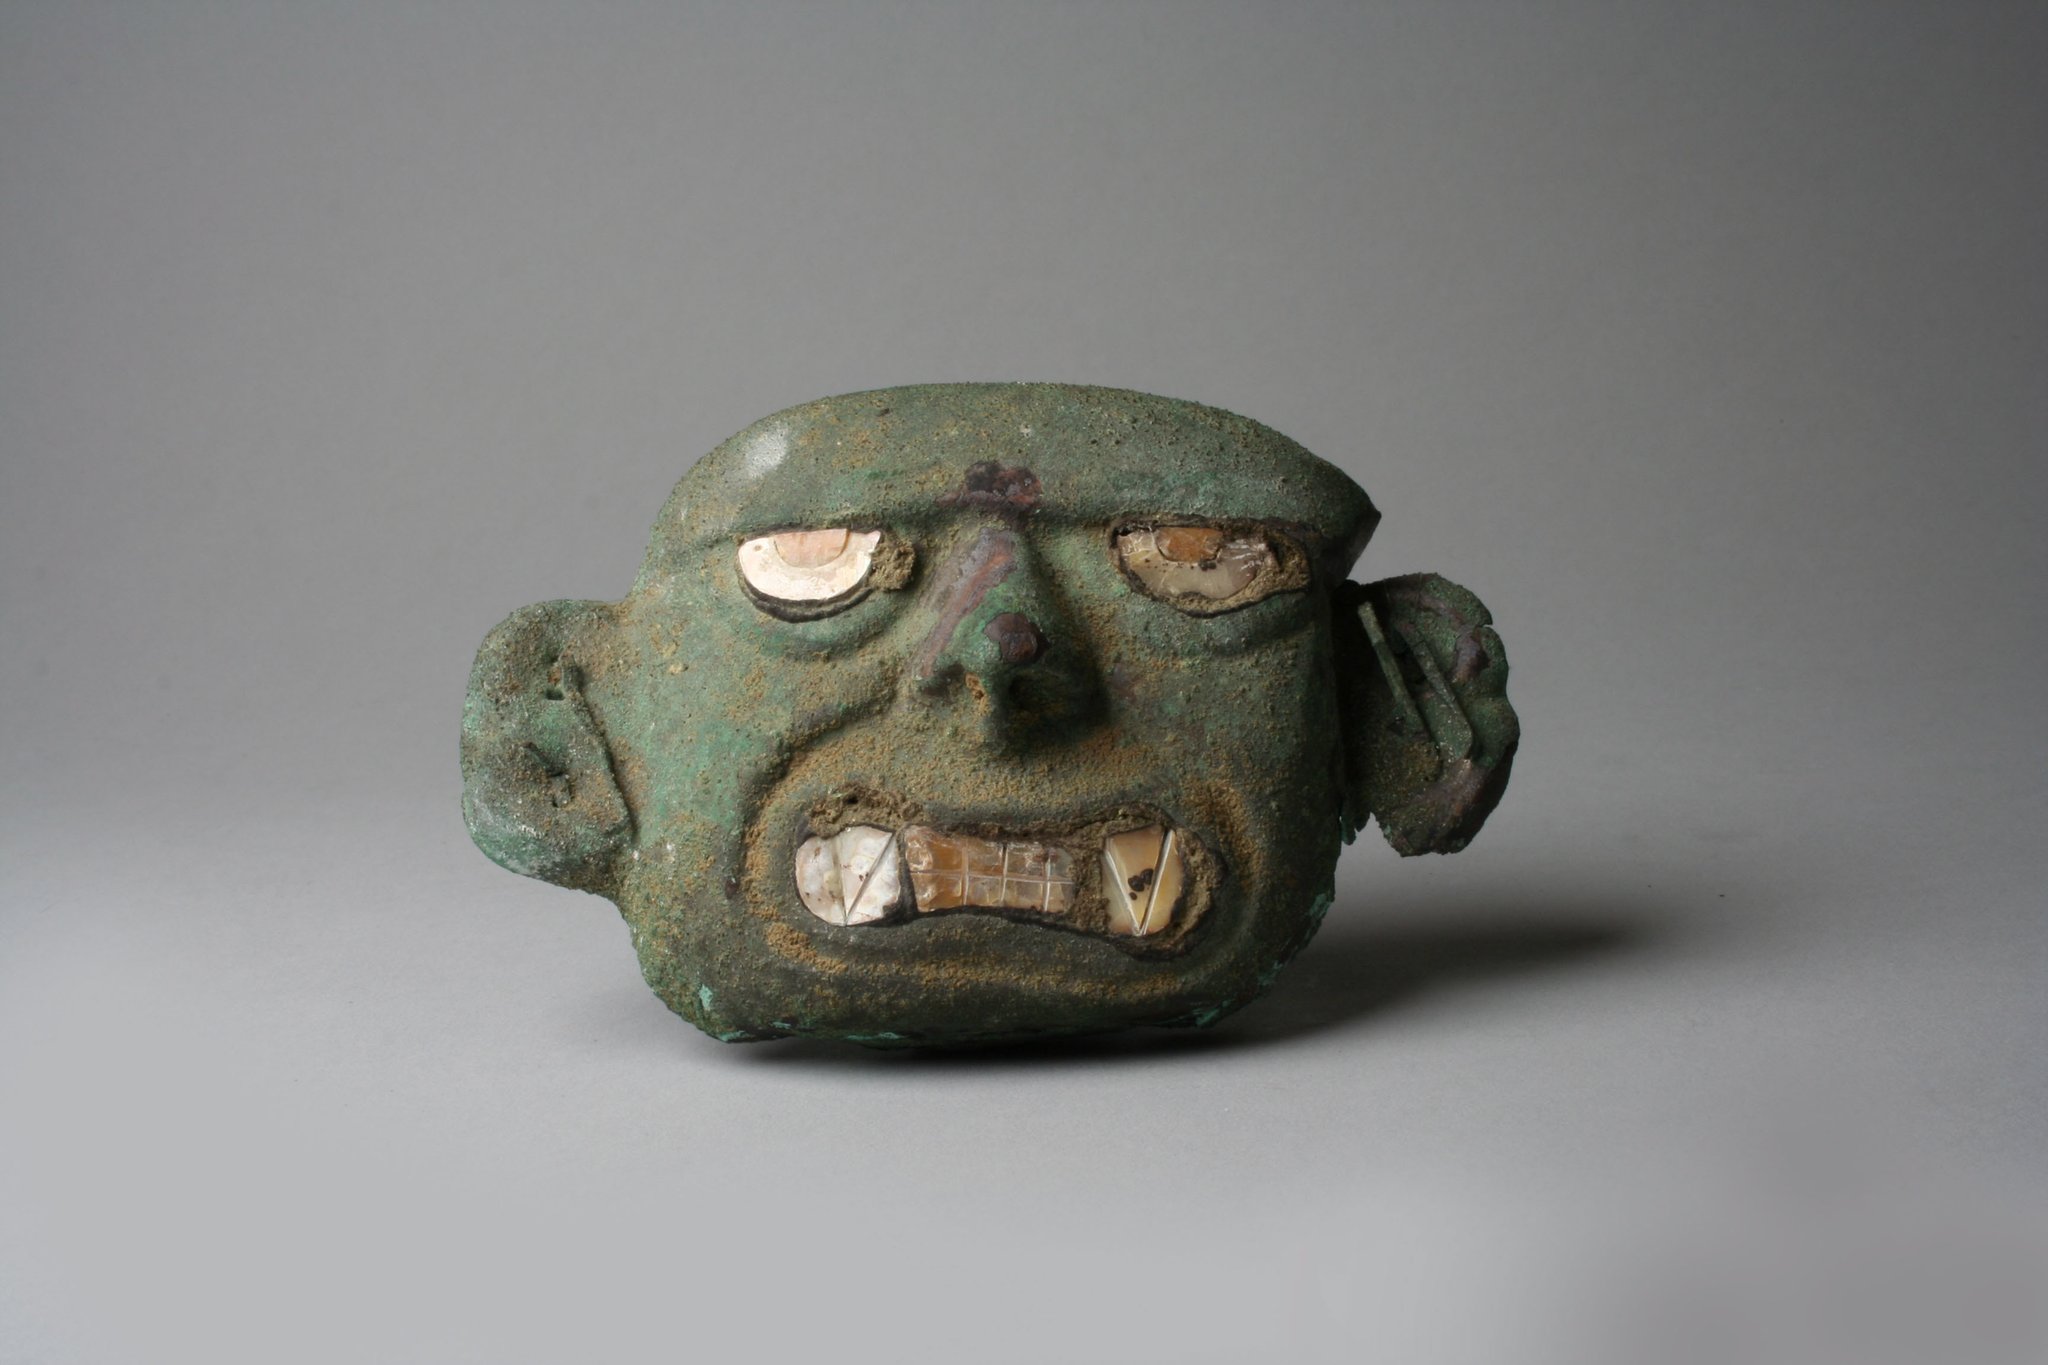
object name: ornament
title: Face Mask Ornament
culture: moche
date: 501-700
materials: shell, metal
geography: peru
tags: masks